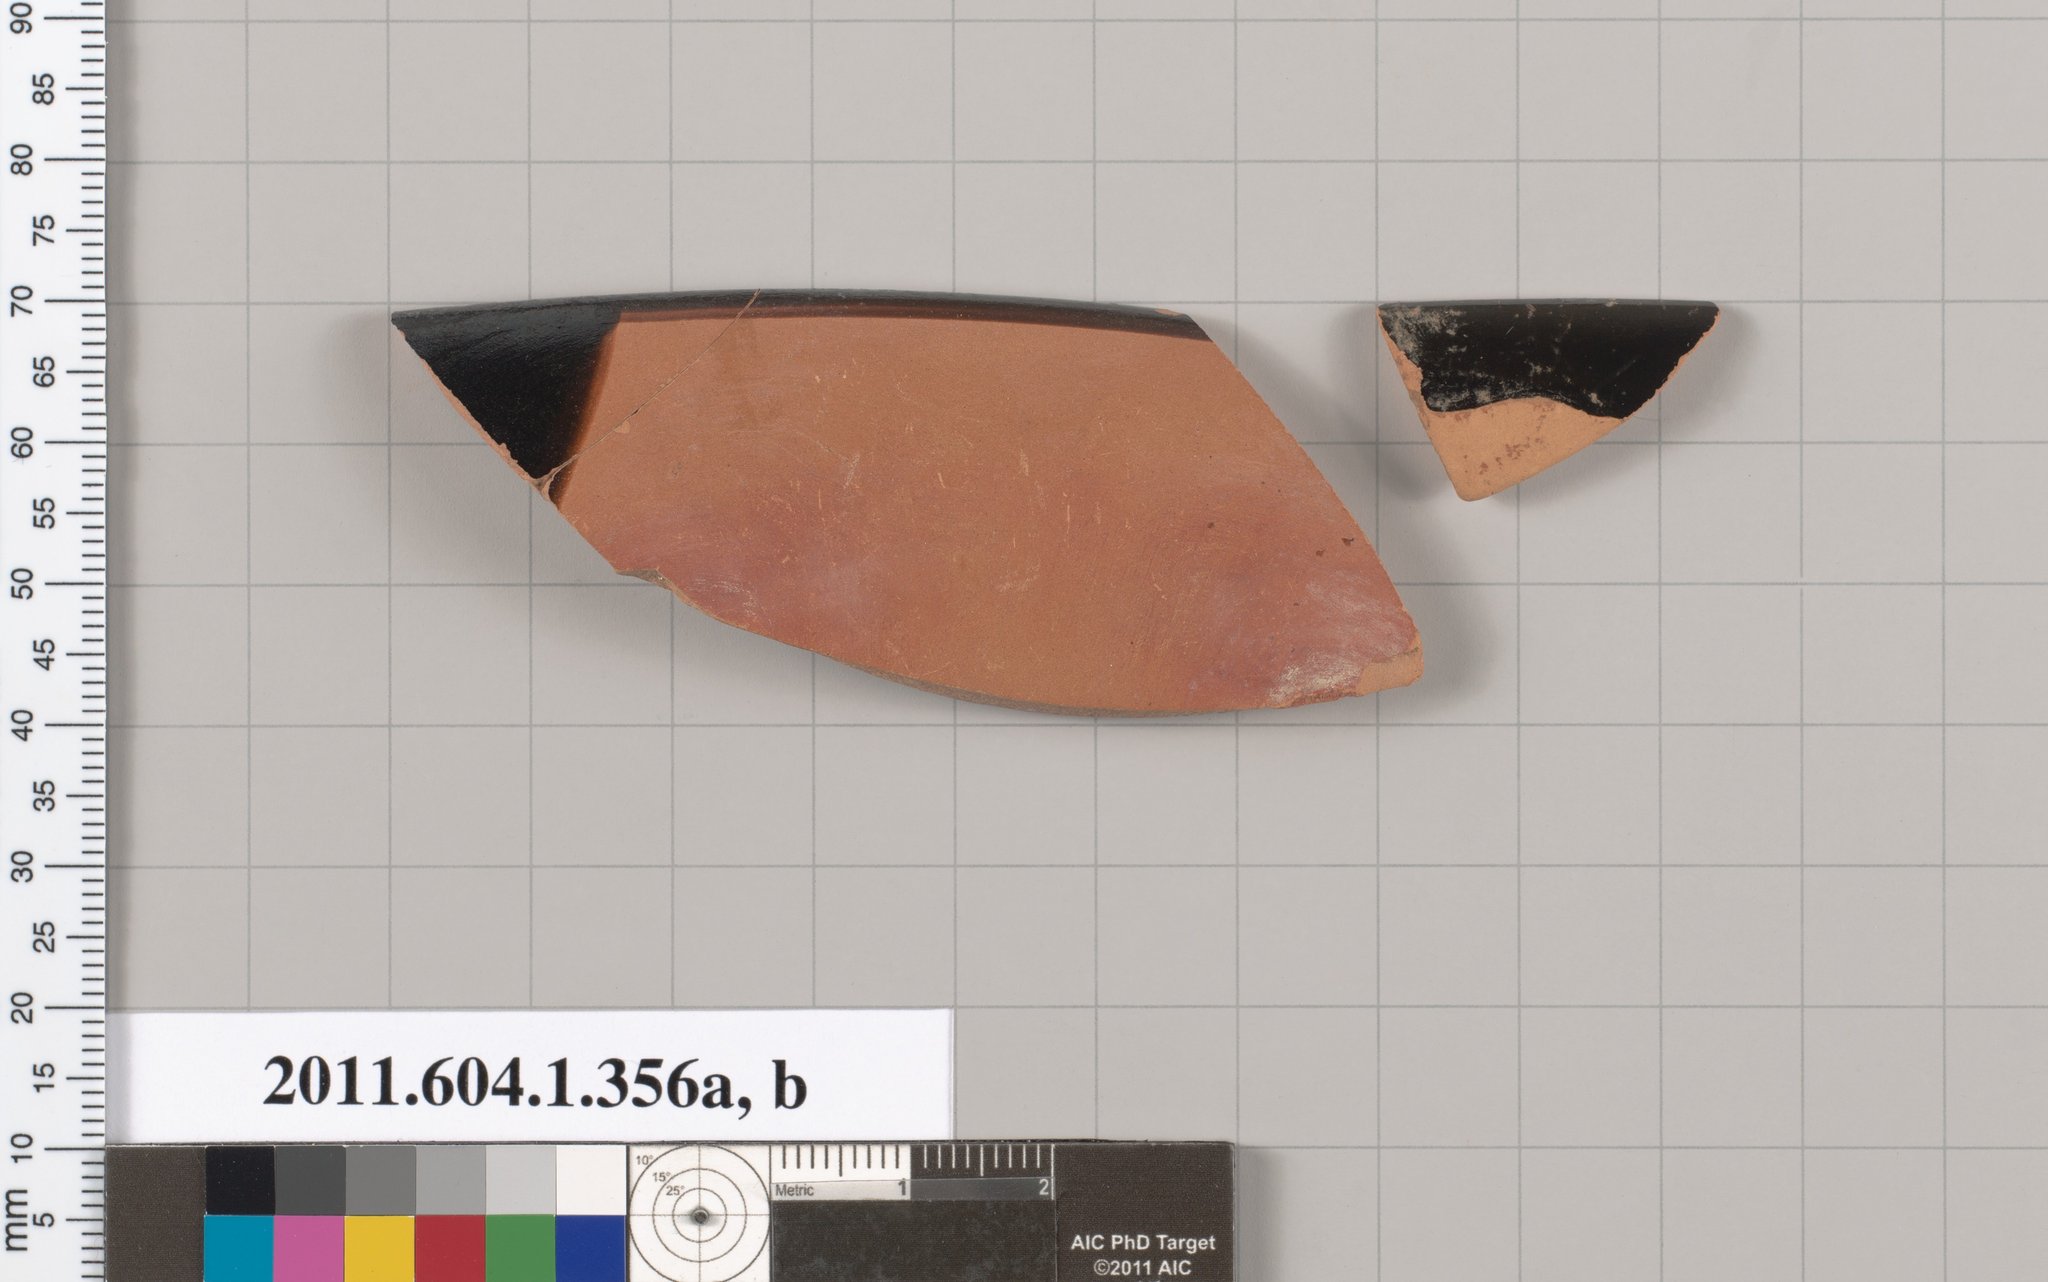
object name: kylix fragment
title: Terracotta rim fragments of a kylix (drinking cup)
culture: greek, attic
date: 475-451 BCE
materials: terracotta